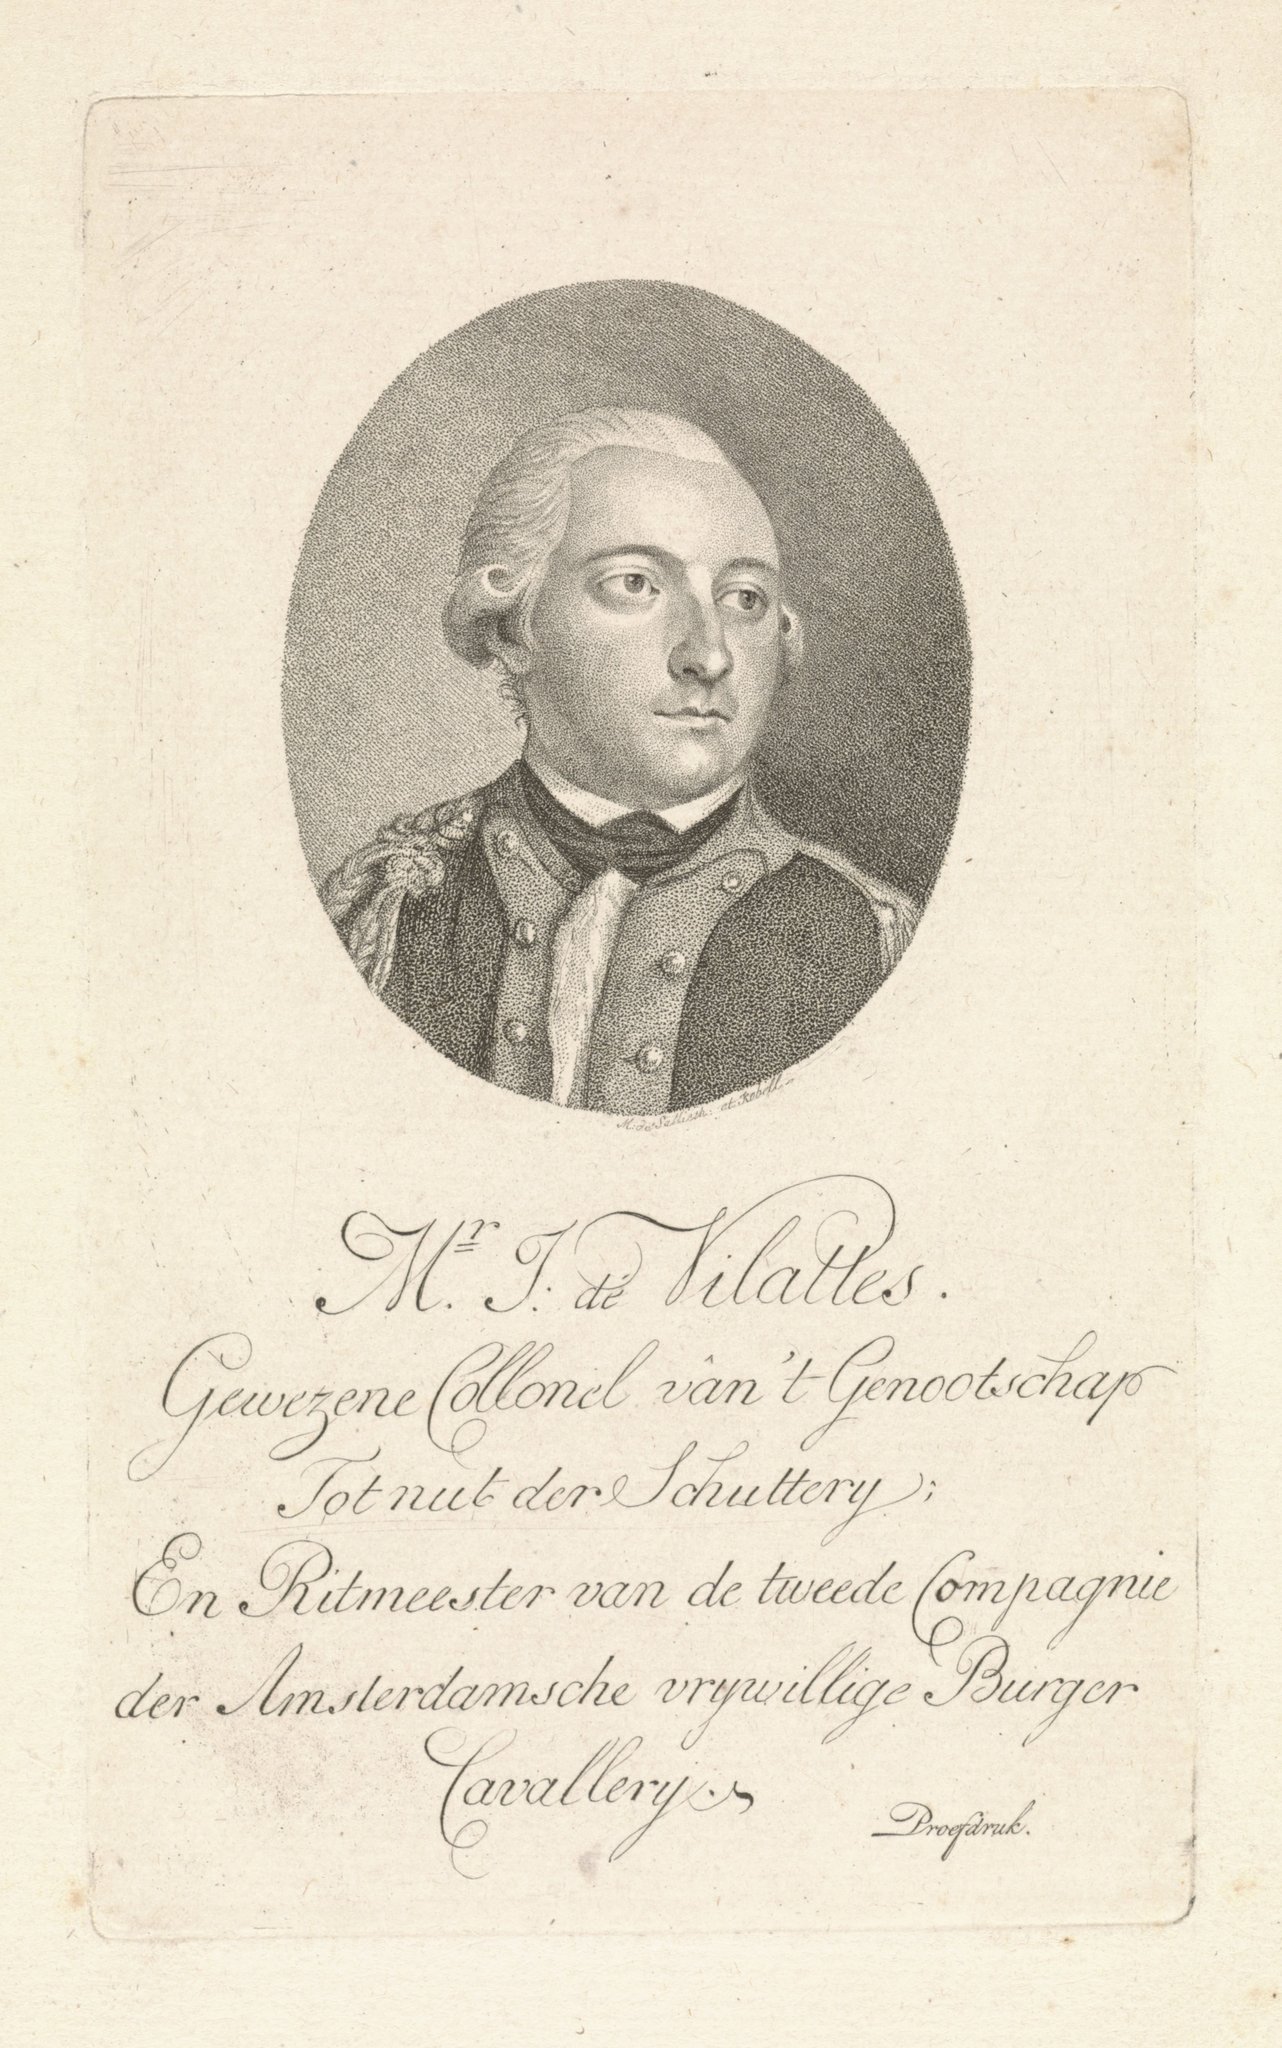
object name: print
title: Portret van Jean Henri des Villates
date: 1764-1791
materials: paper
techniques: etching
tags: advocaat, jean henri des villates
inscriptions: collector's mark: Lugt 2228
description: Portret van Jean Henri des Villates, advocaat, ritmeester en schrijver.